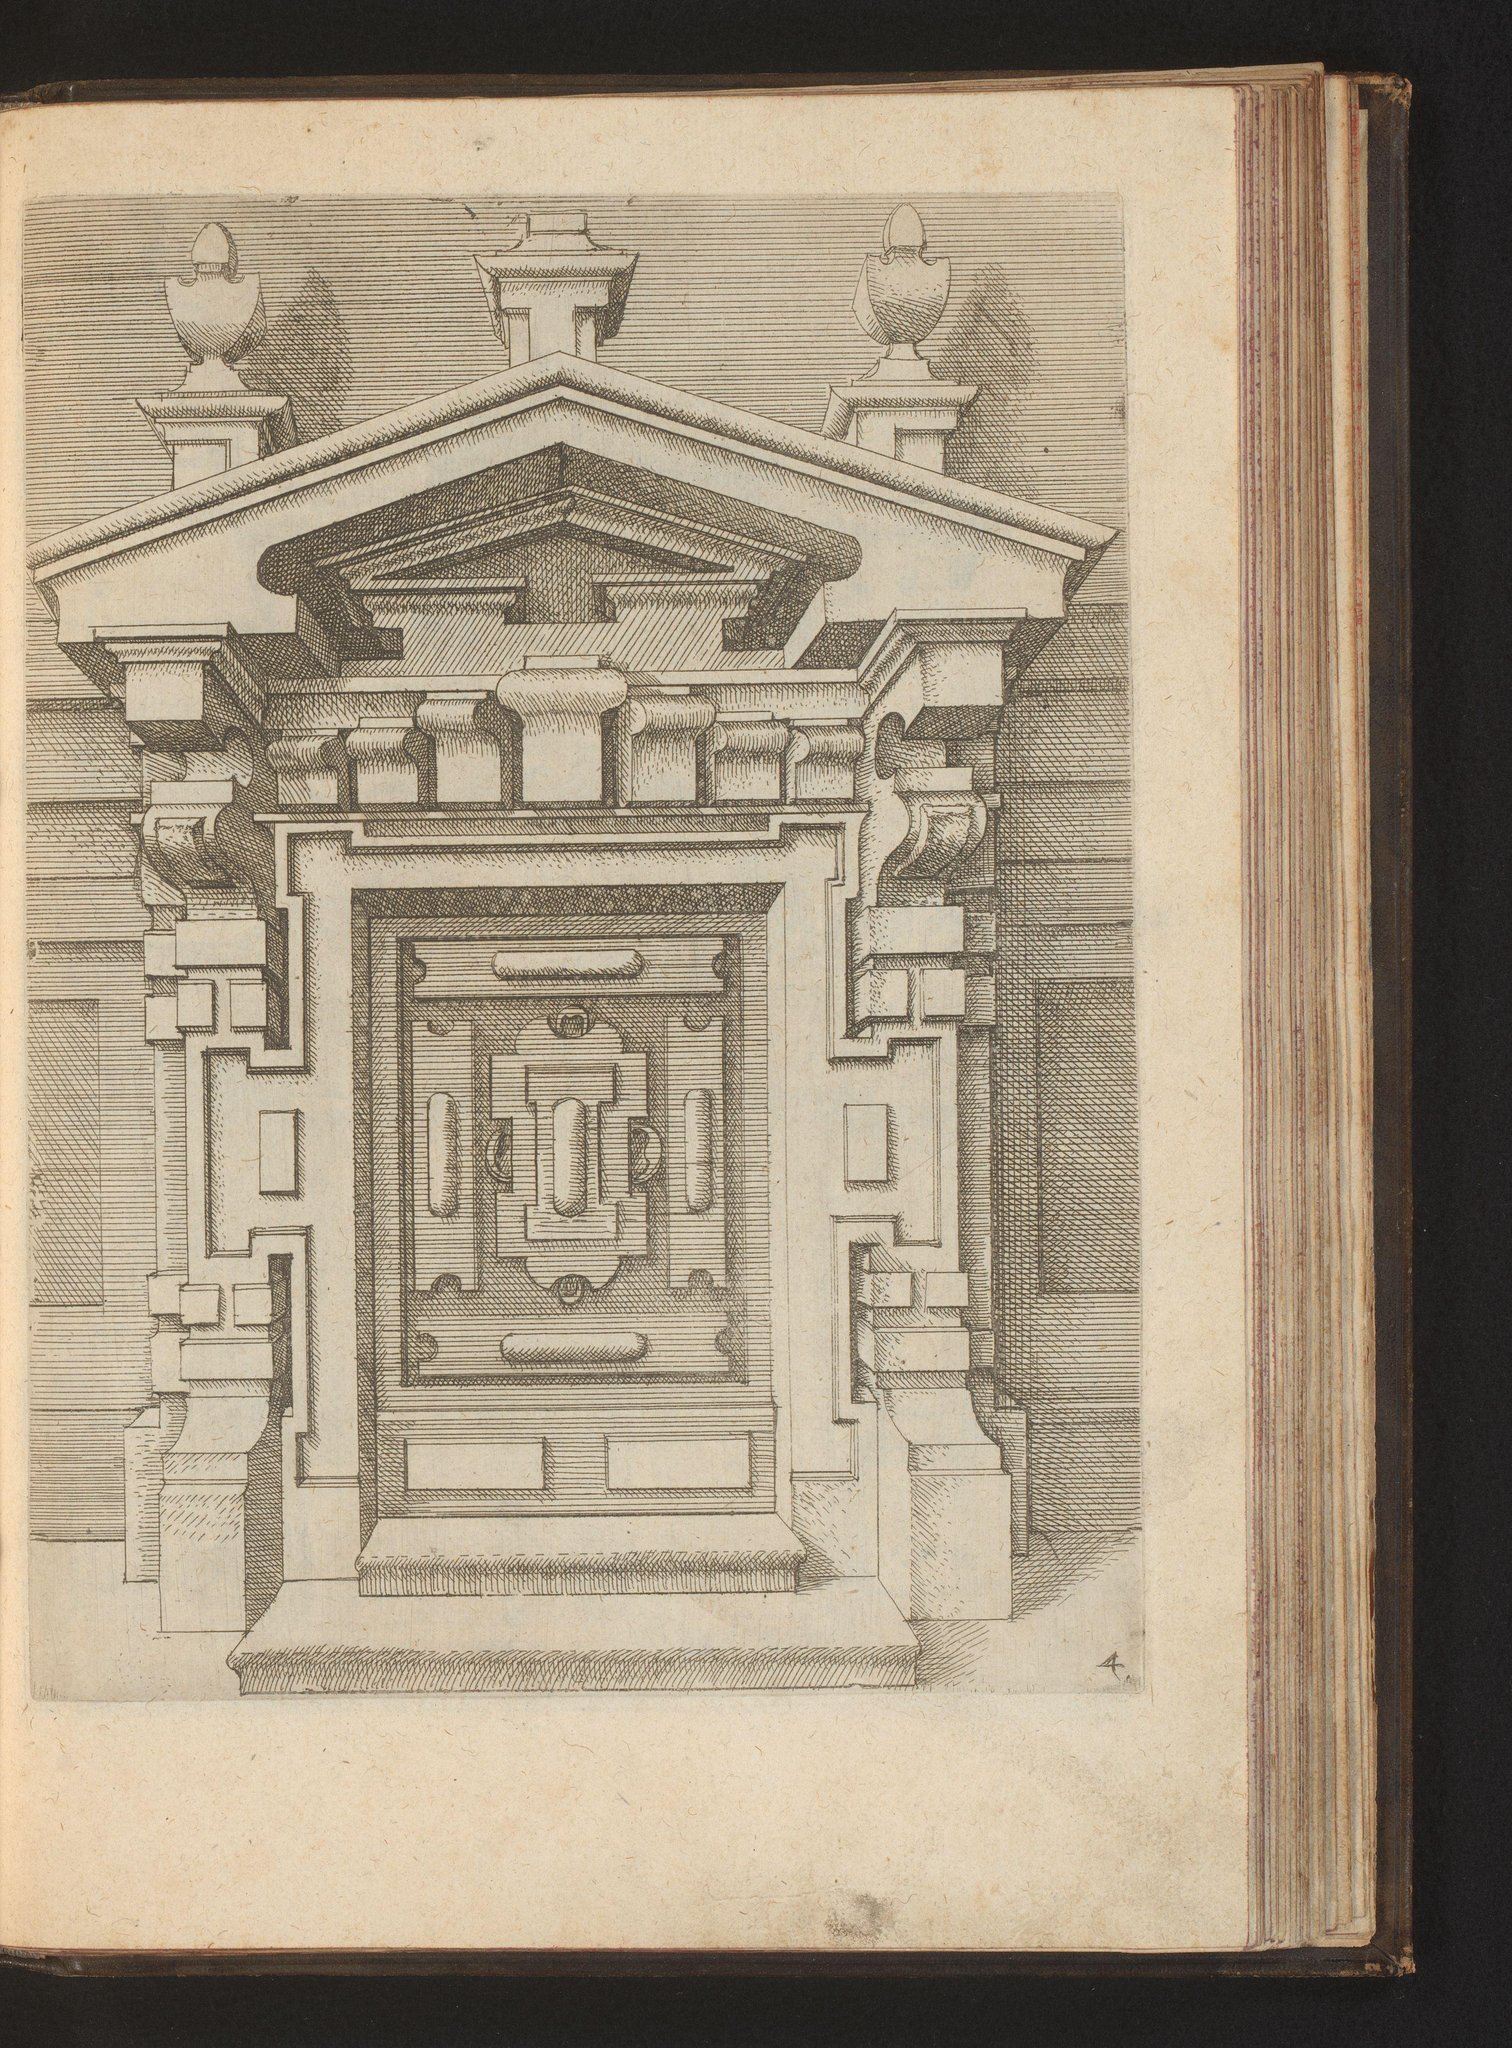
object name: ornament print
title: Portaal in de Toscaanse orde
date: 1593-1595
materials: paper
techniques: etching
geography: straatsburg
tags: tuscan order ~ architecture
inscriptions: collector's mark: Lugt 2228, collector's mark: Lugt 2760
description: Prent gebruikt in: Dietterlin, Wendel (I). Wendel Dietterlin, Architectura de Polstium seu Portalium ornatu uario Liber II. Straatsburg: Bernhard Jobin, 1594.